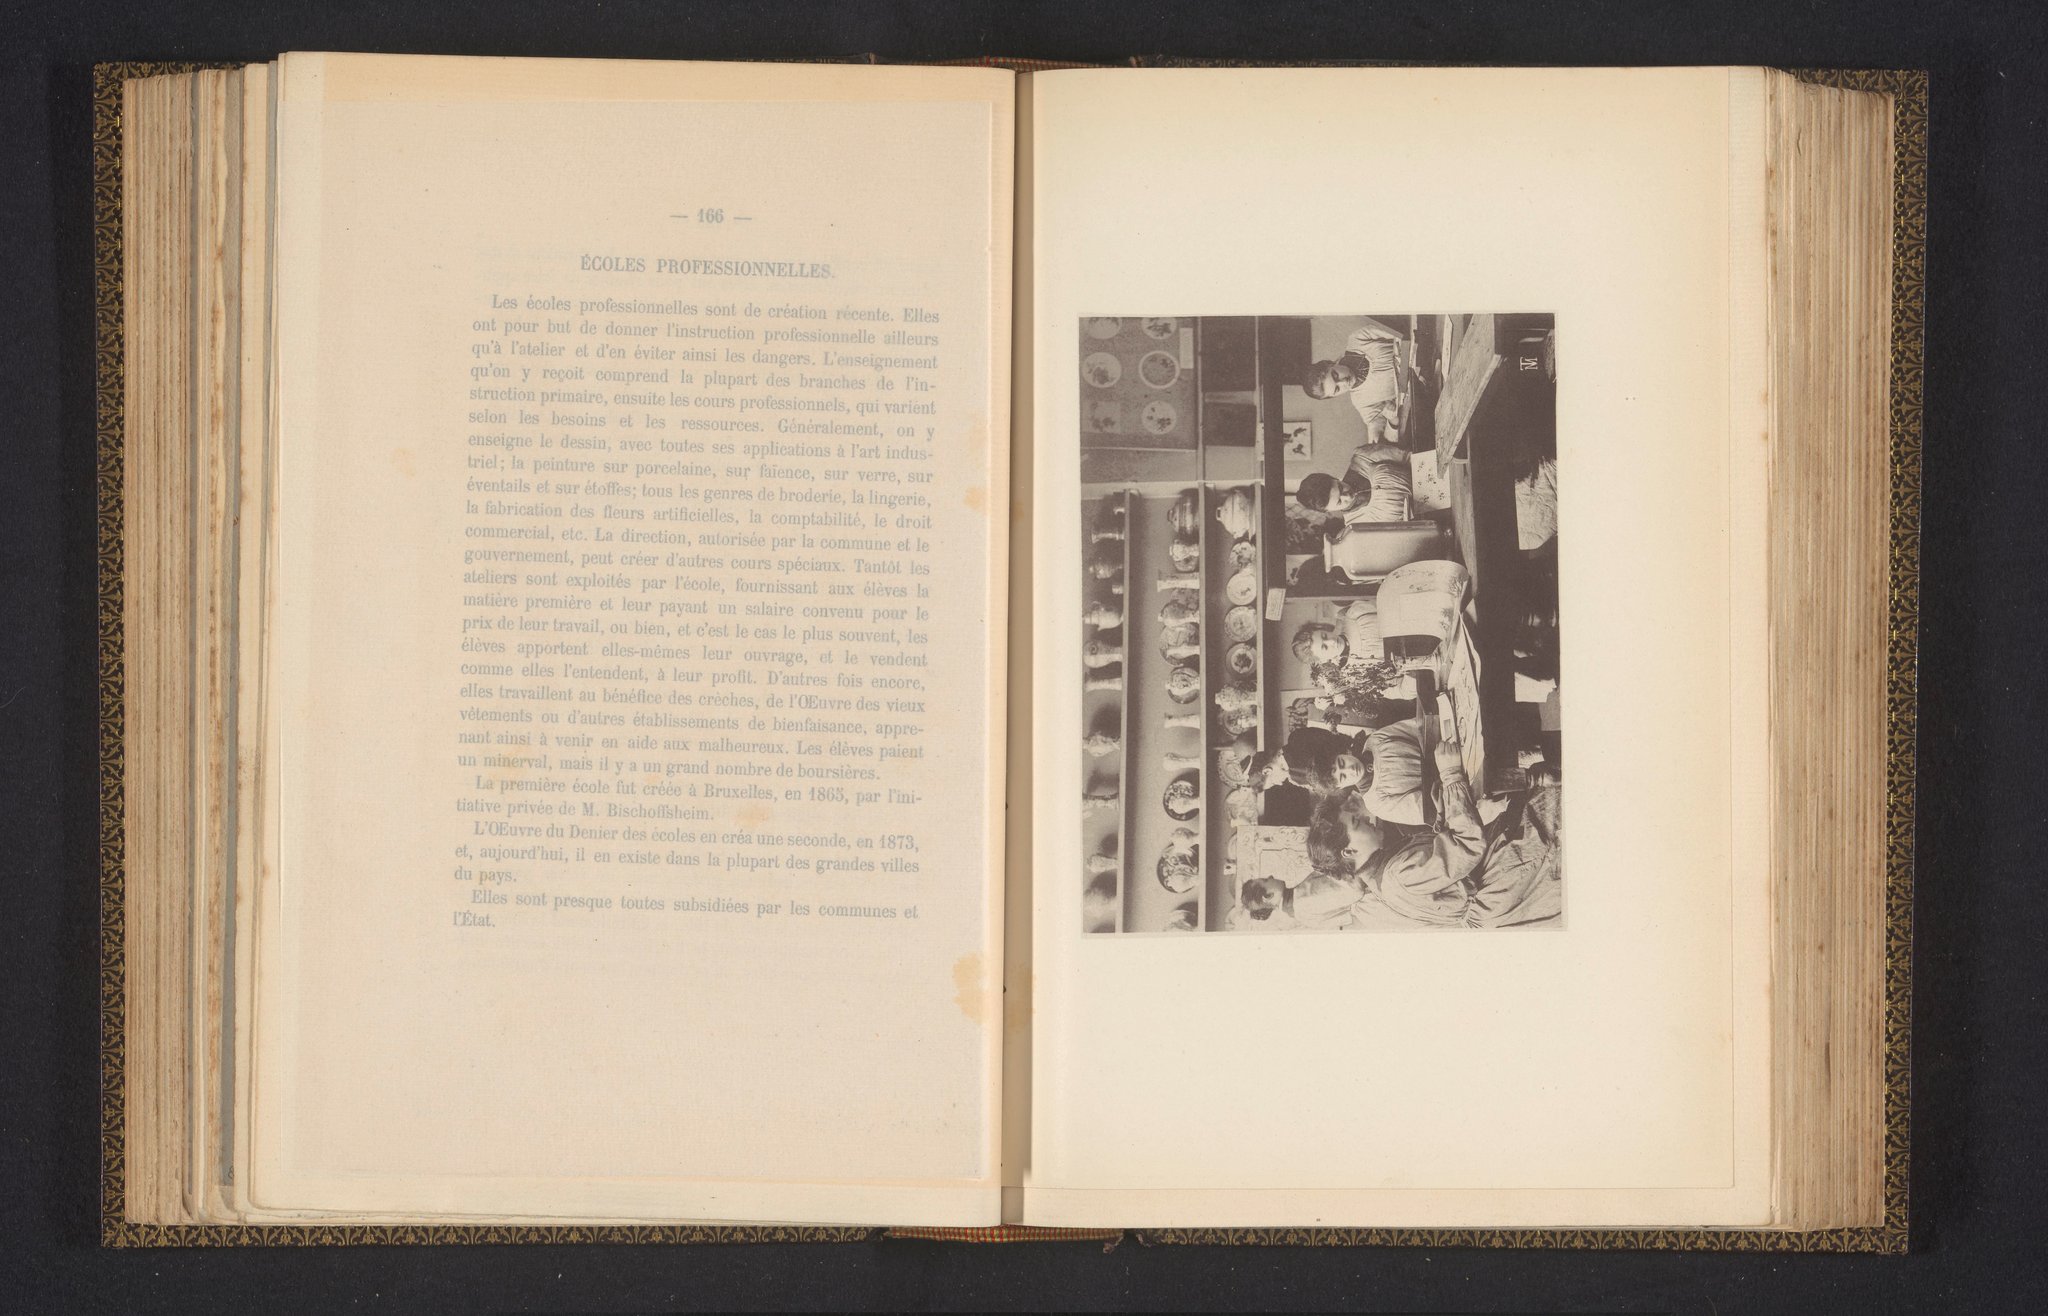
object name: photomechanical print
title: Gezicht op een schoolklas waar een schilderles aan de gang is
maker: Anonymous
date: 1888-1893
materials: paper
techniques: photograph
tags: painting (including book-illumination, miniature-painting), elementary school; class, form